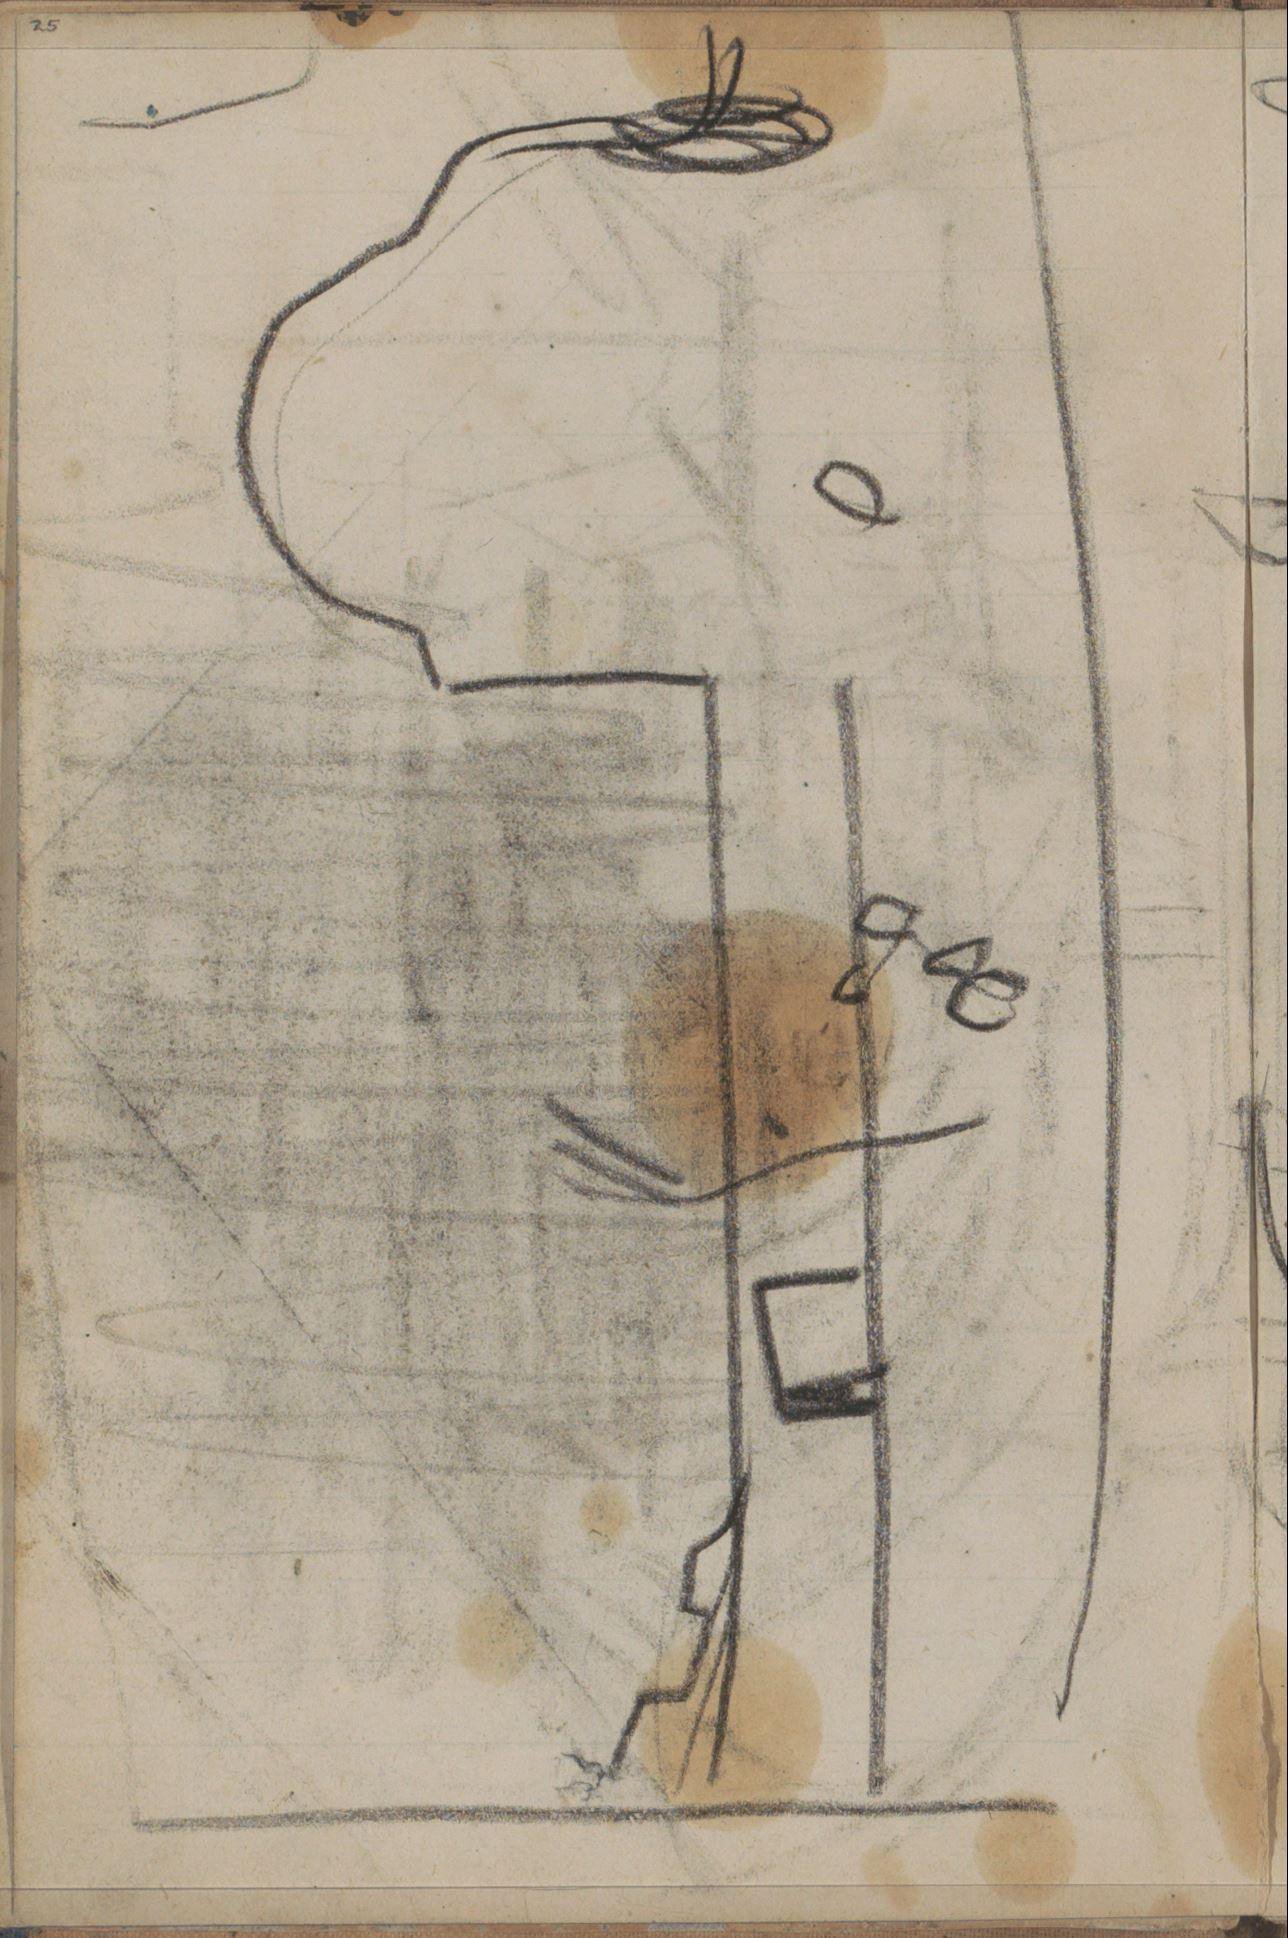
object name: sketchbook leaf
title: Studie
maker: marius bauer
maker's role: draughtsman, print maker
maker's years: 1867-1932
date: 1888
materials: chalk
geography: istanbul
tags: architecture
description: Mogelijk een weg met het silhouet van een gebouw. Pagina 25 uit een schetsboek met 58 bladen.